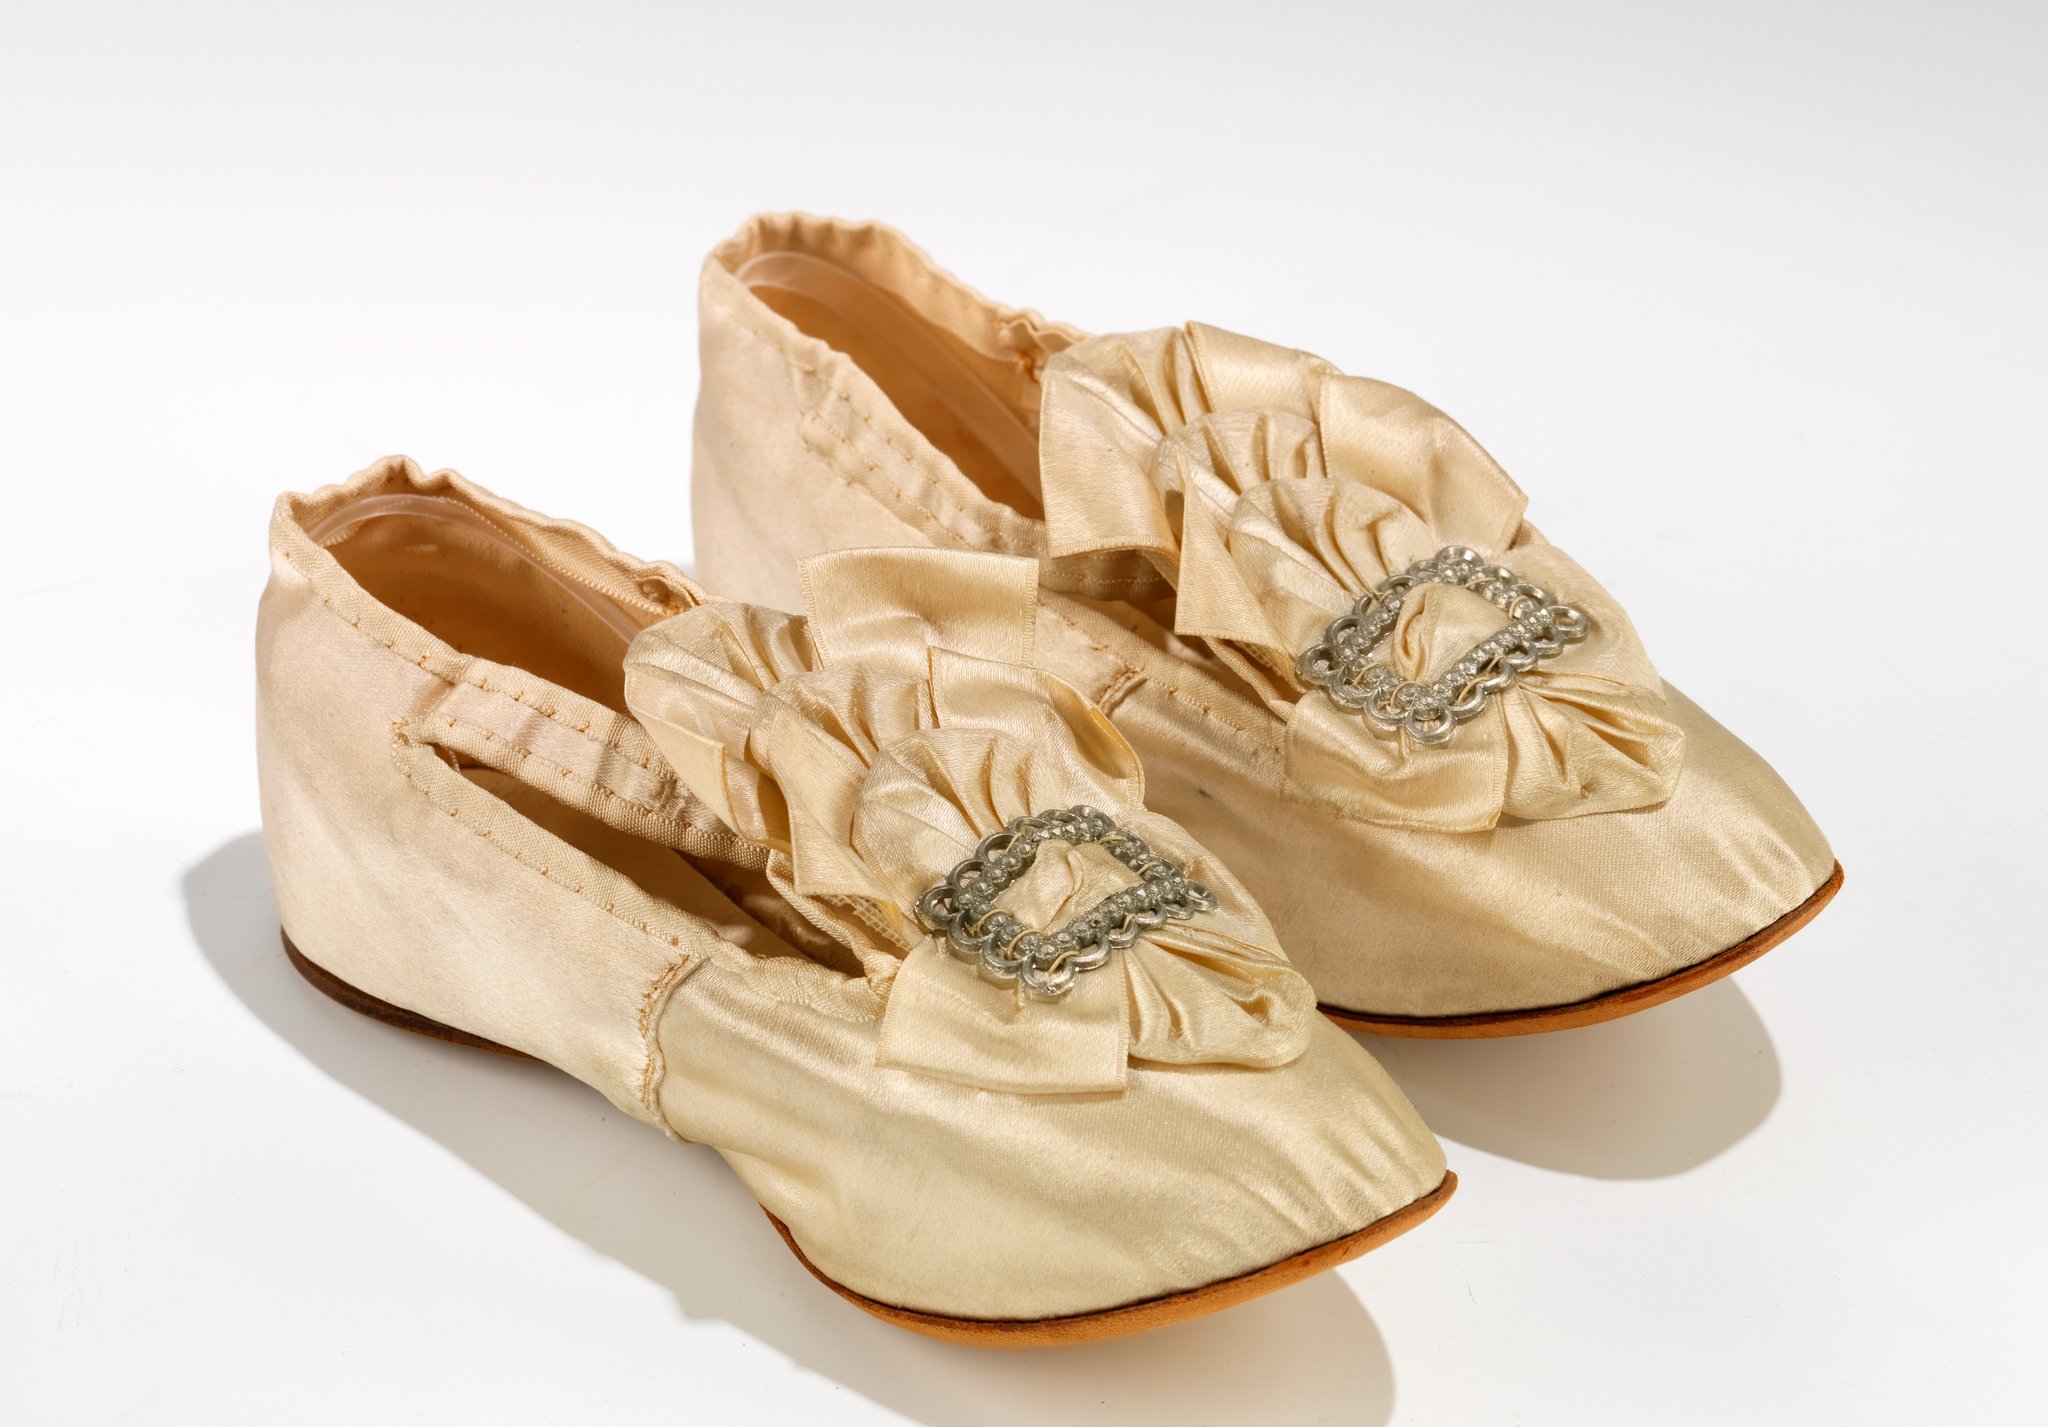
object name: shoe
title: Shoes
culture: french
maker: hattat frères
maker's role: designer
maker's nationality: french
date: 1880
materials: silk